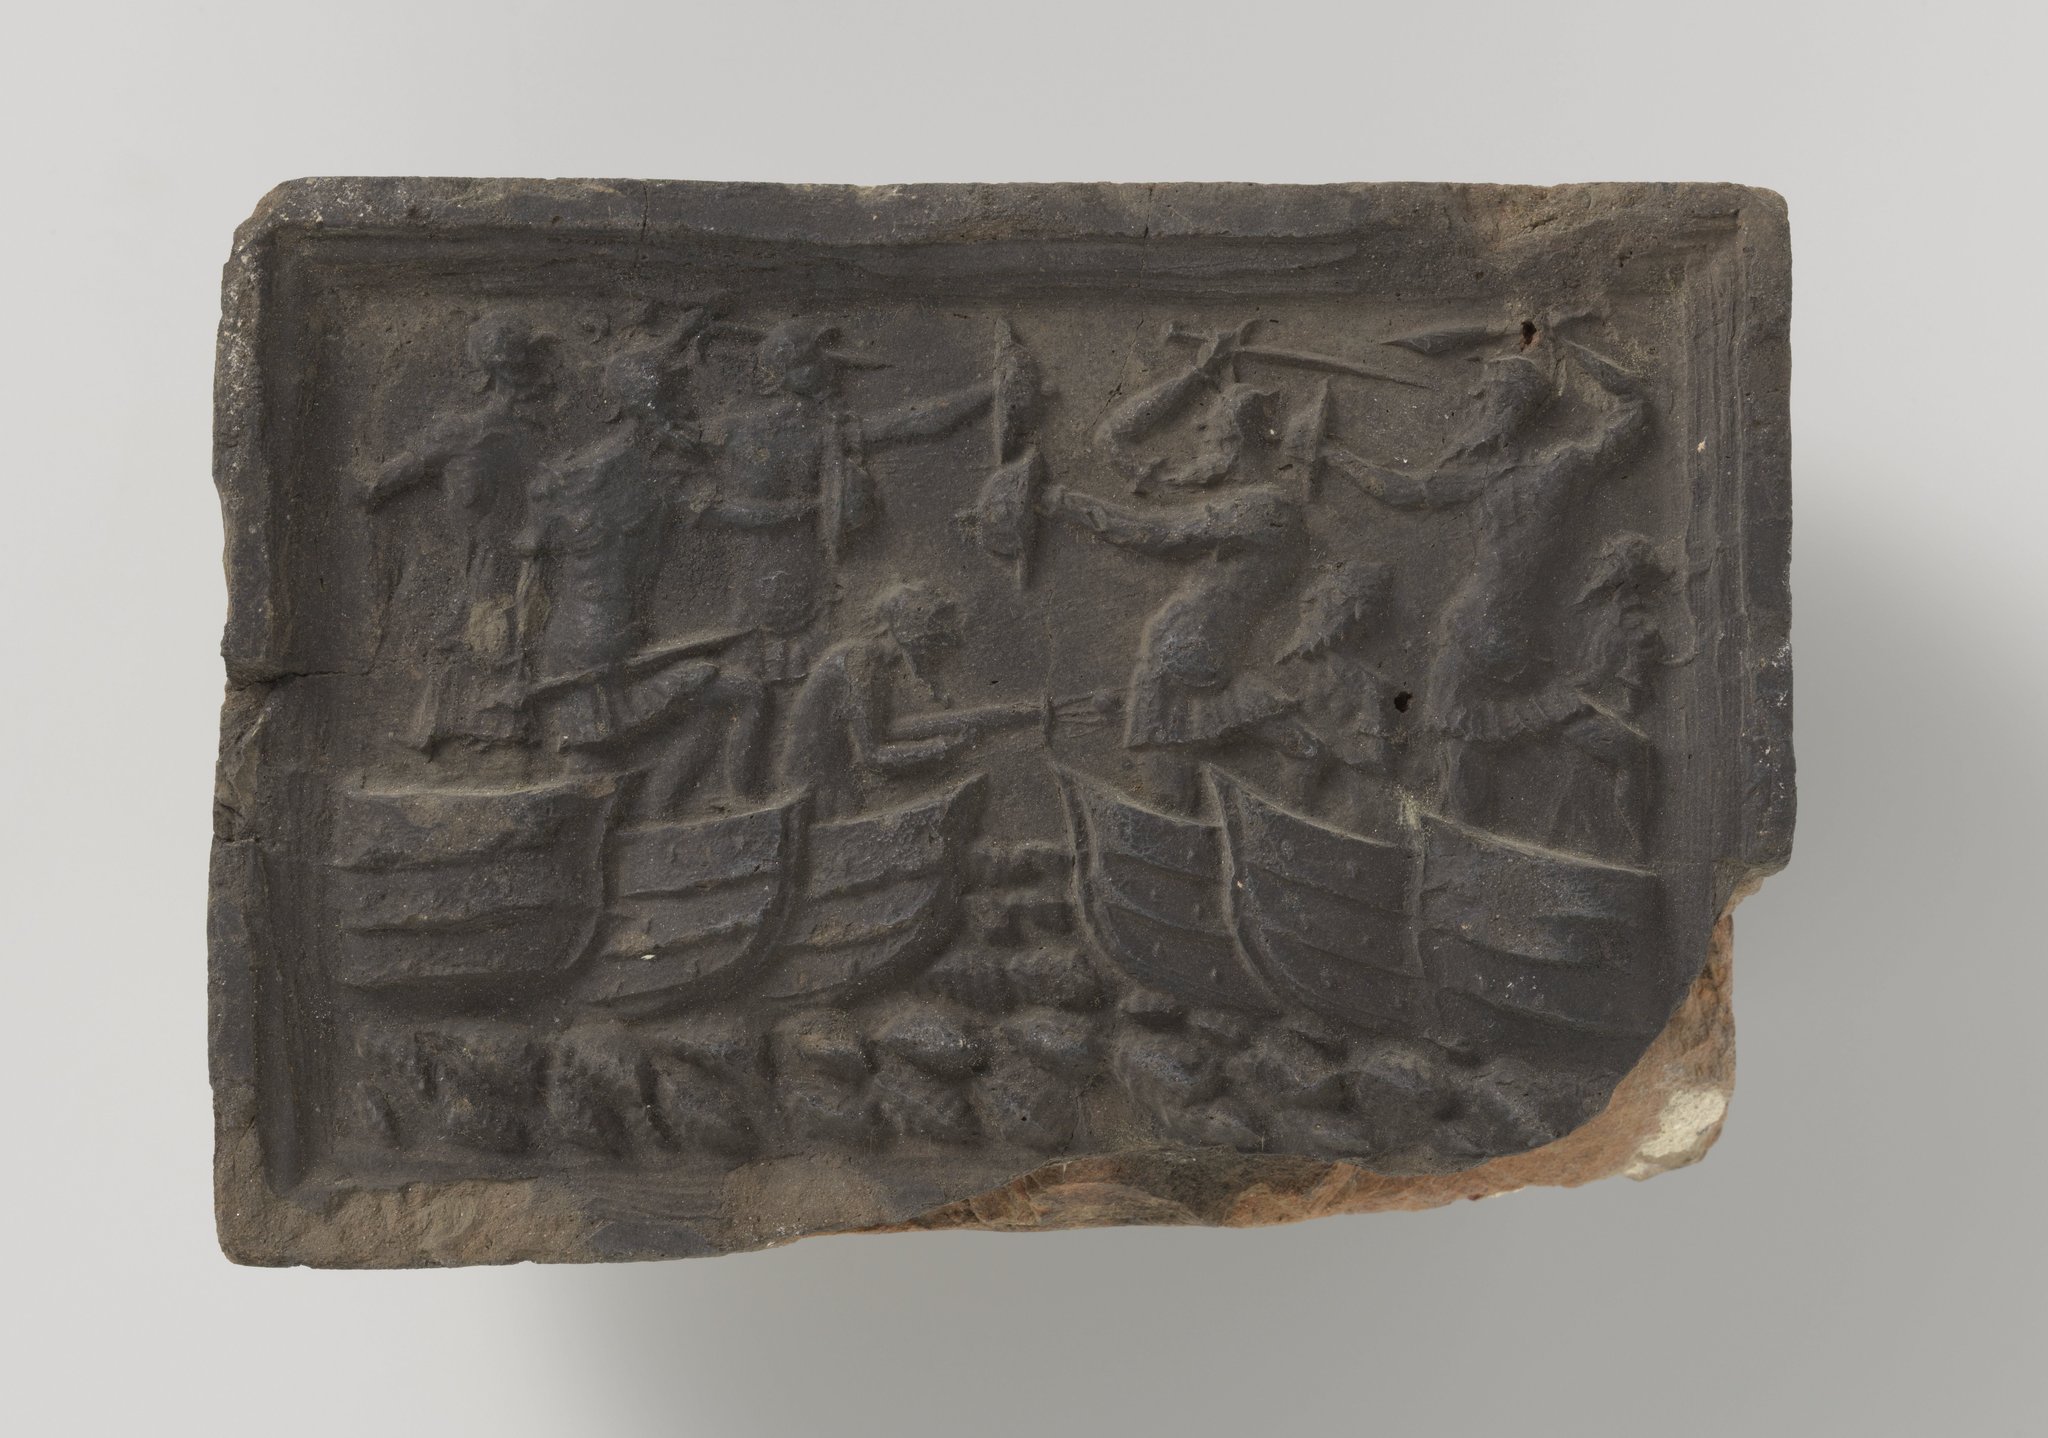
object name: hearthstone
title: Zeegevecht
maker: Anonymous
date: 1500-1600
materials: earthenware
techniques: printing, firing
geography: southern netherlands